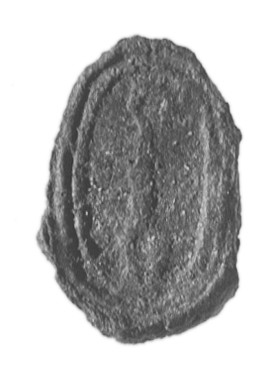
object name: sealing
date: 2030-1640 BCE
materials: clay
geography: egypt